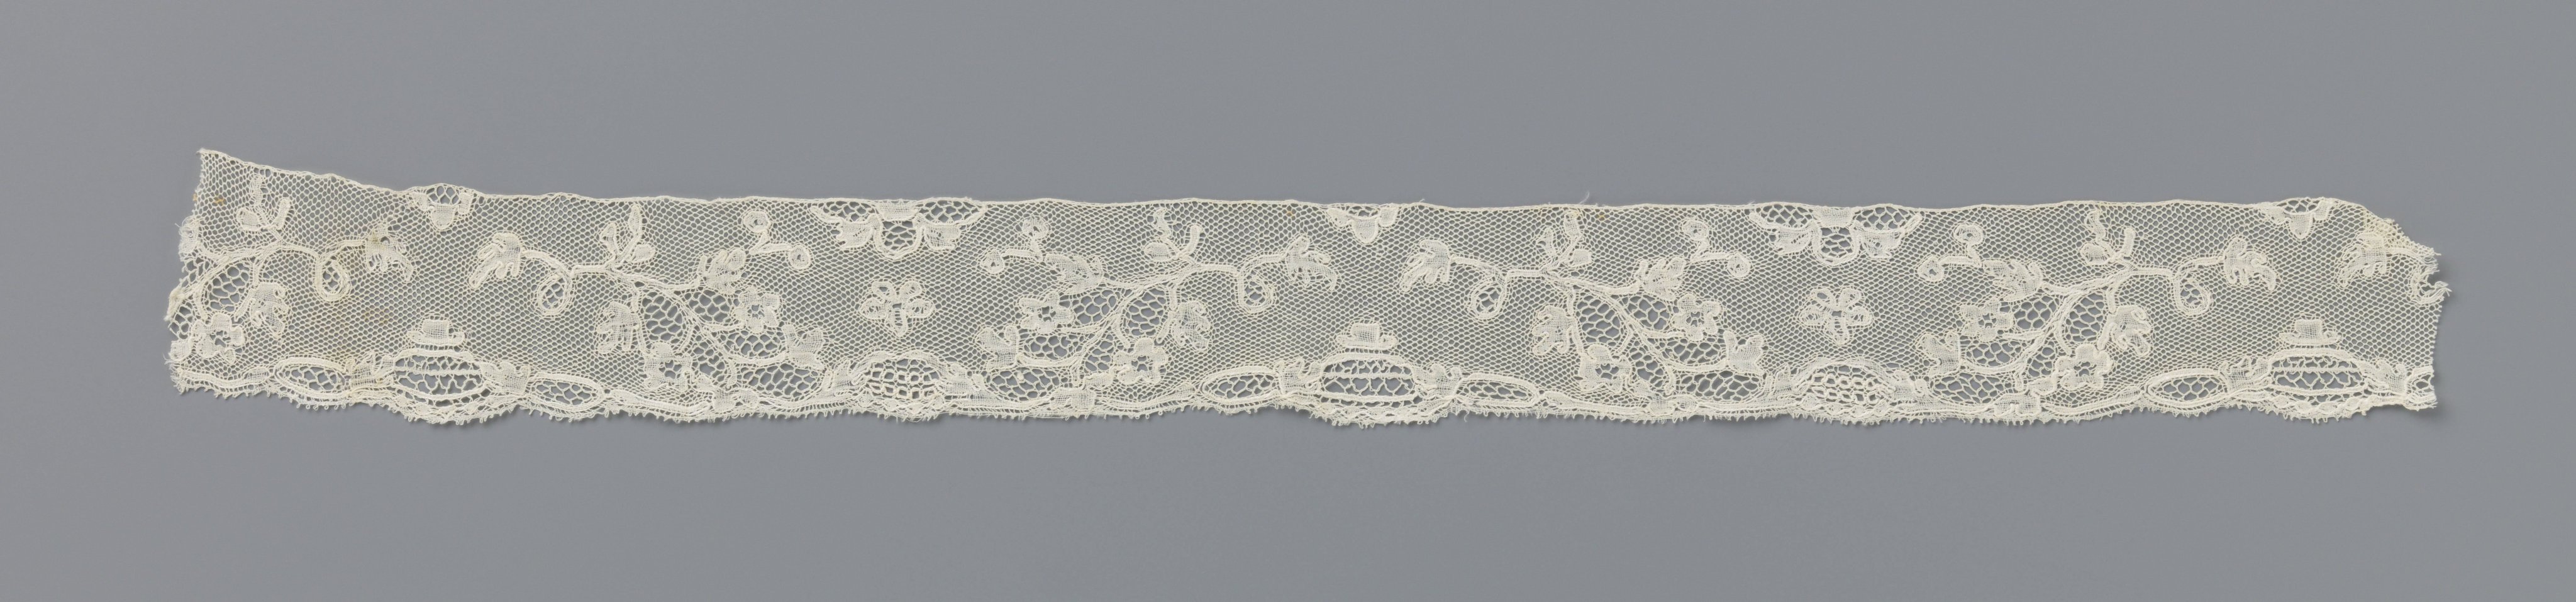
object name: strip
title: Strook kloskant met toegewende takken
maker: Anonymous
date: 1775-1799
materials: linen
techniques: lace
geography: southern netherlands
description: Op de traliegrond, een Mechelse grond (ook wel ijsgrond genoemd), staan twee symmetrische, toegewende en schuin neerhangende takken, waarvan de zijtakken met blad en bloempje een ovaal oversnijden dat met rasterwerk gevuld is. In de flauw geschulpte rand kleinere ovaaltjes. Tegen de rechte binnenzijde staan gehalveerde kruisbloemen en rozetjes. Mechelse kant.